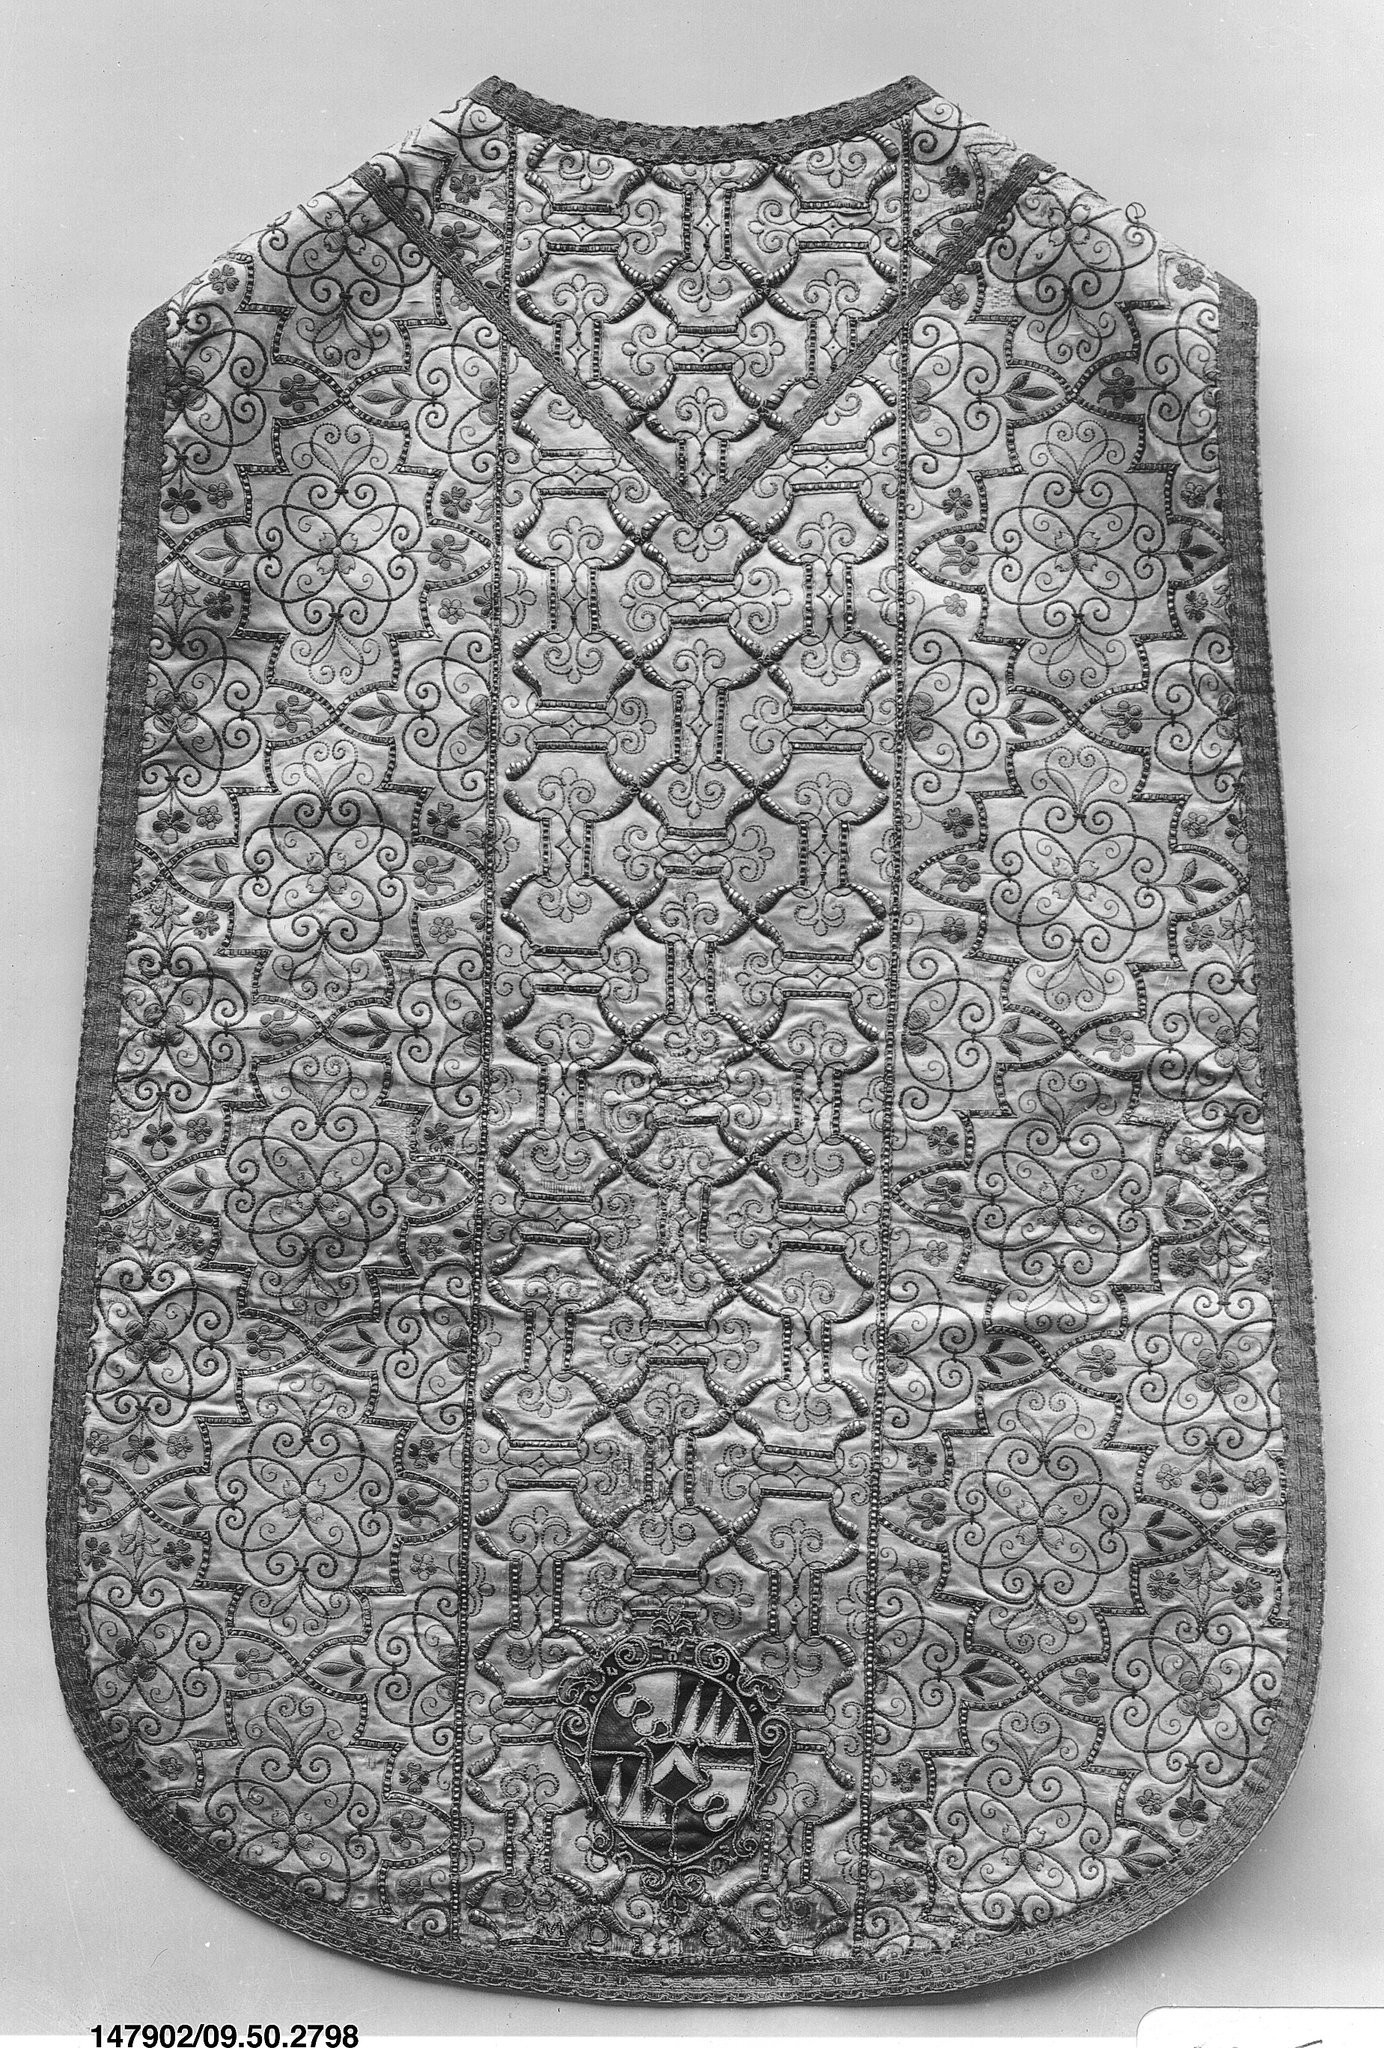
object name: chasuble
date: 1610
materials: metal thread, silk